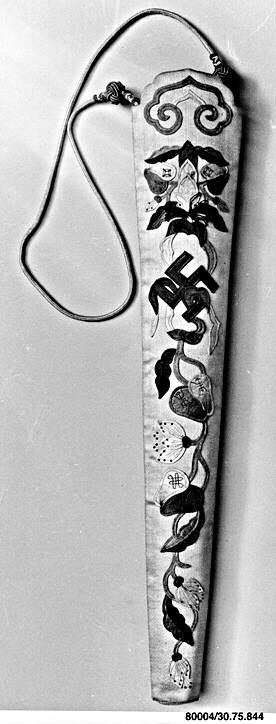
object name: fan holder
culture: chinese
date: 1701-1900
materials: metal thread, silk